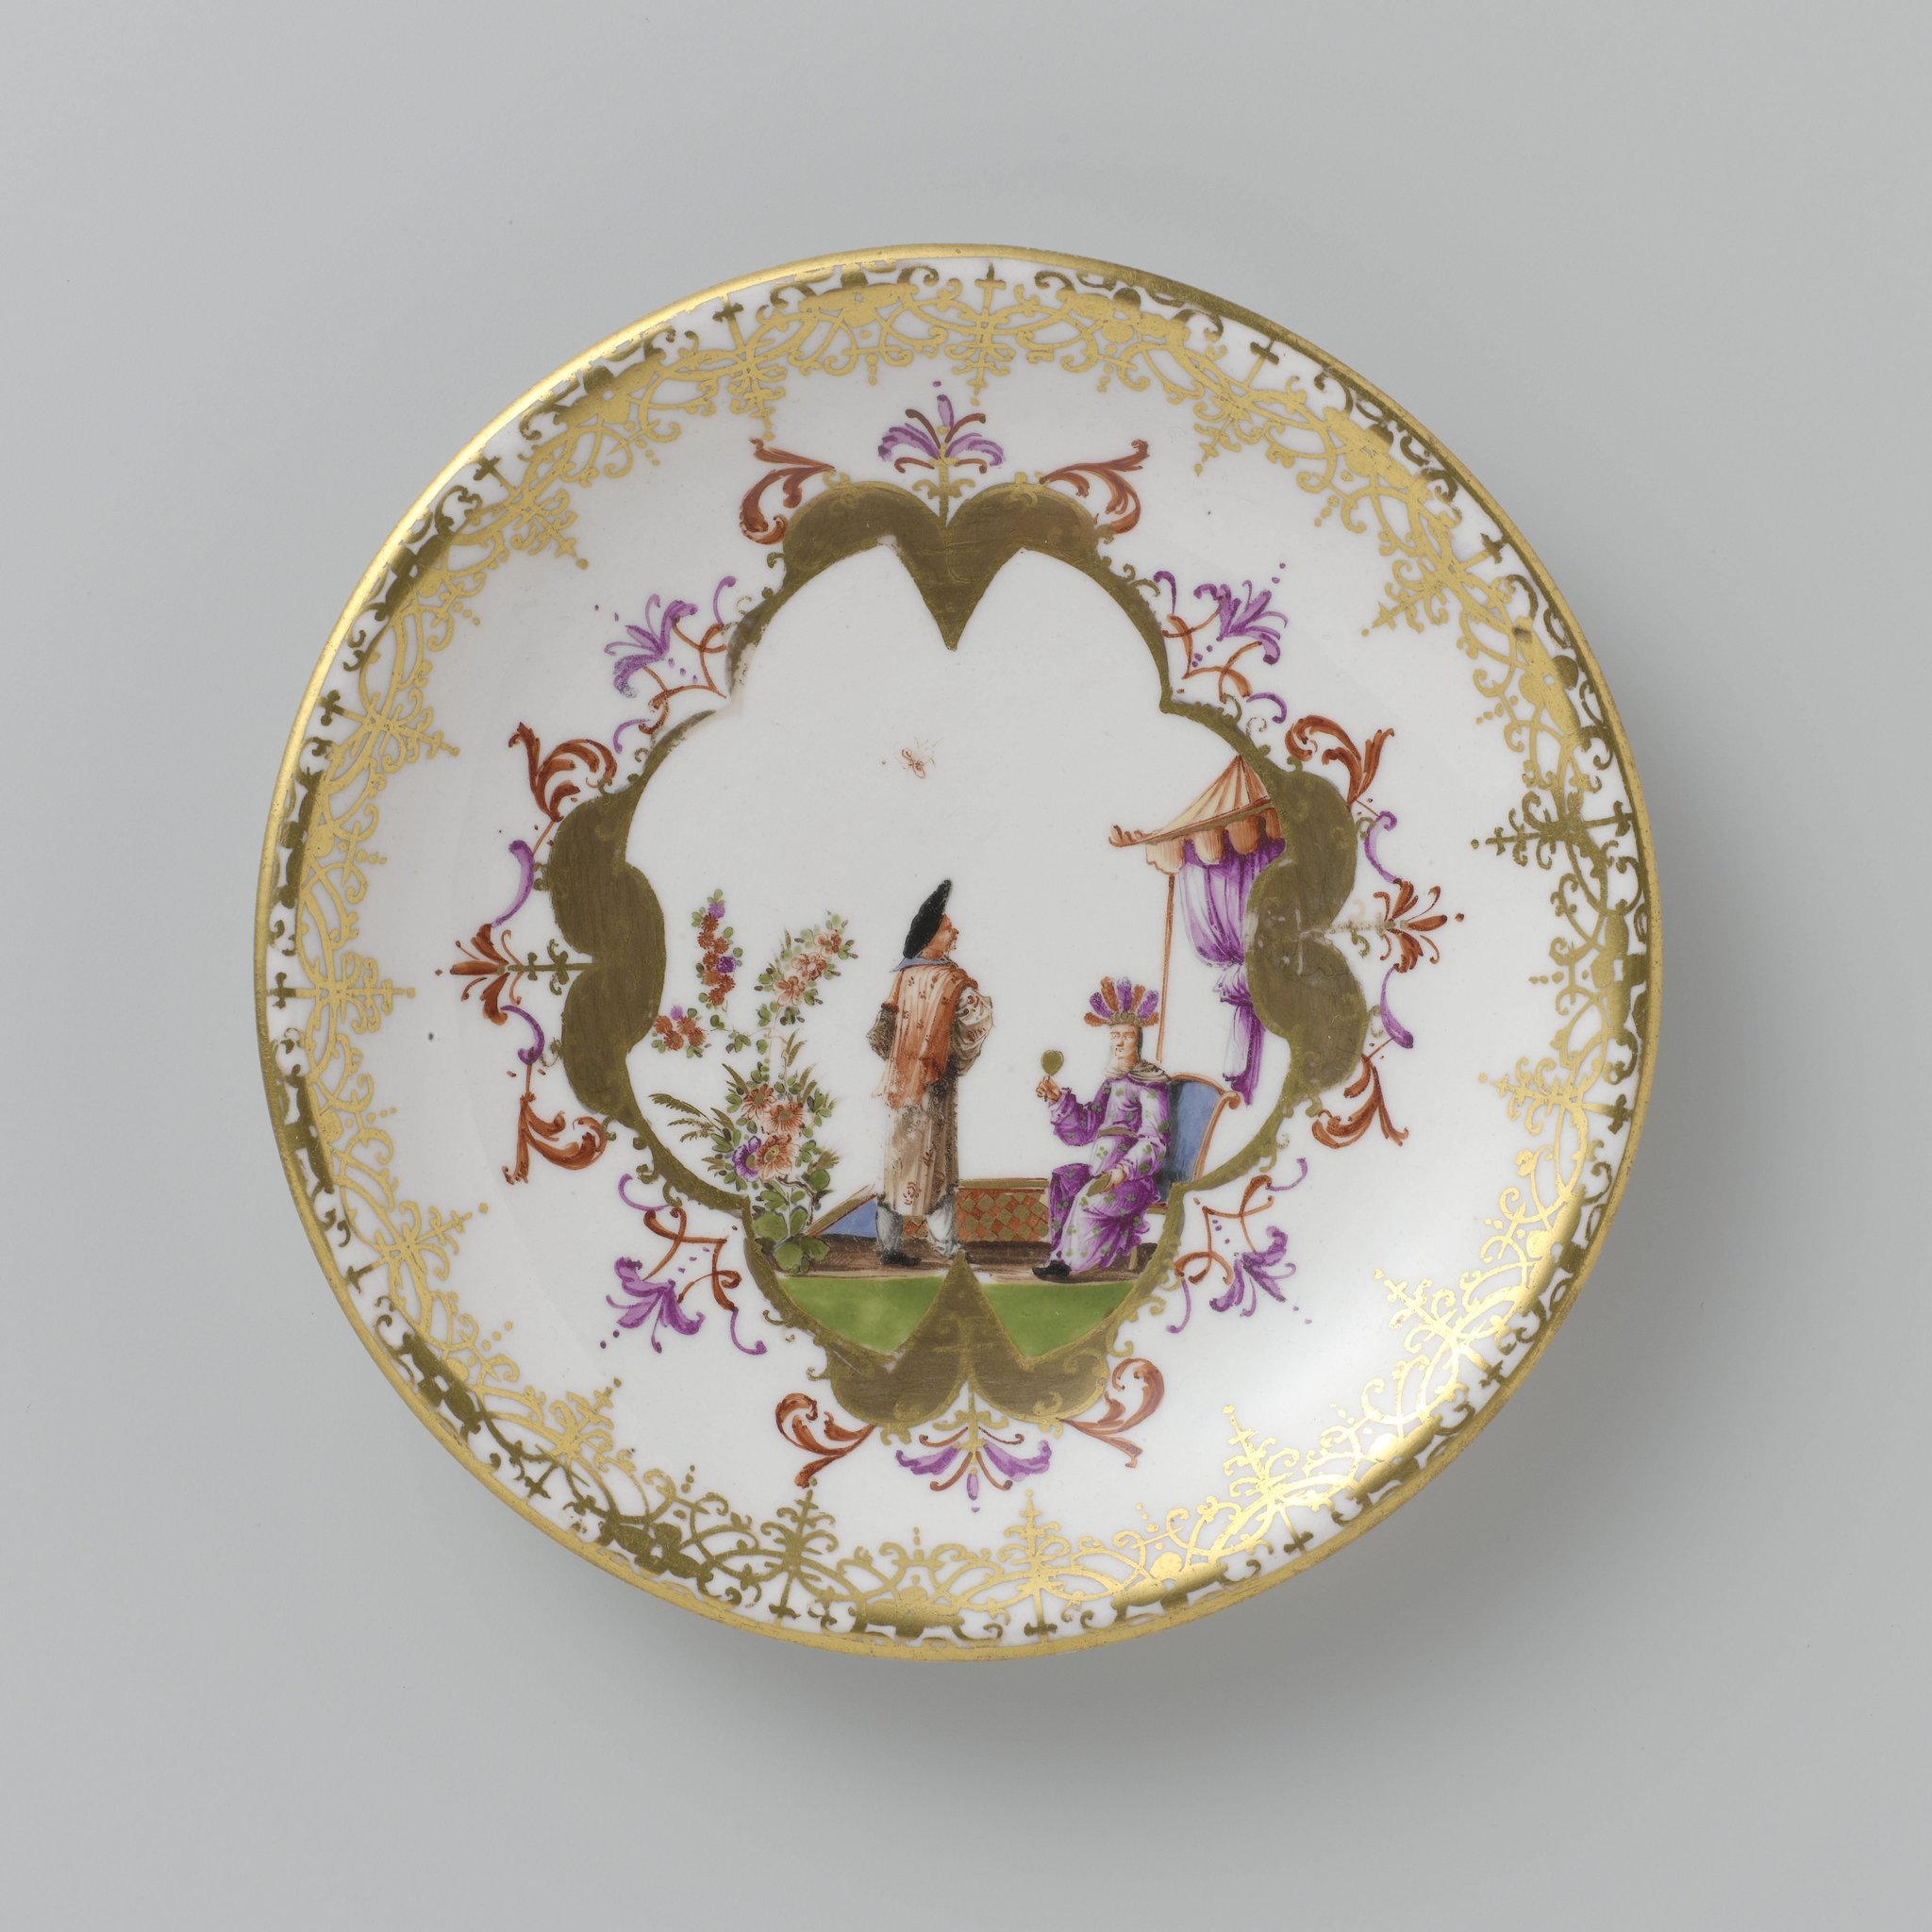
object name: platter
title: Cup and saucer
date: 1725-1730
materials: porcelain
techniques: painted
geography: meissen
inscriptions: label: ‘SAMMLUNG / Dr. FRANZ OPPENHEIMER’, number: ‘178.’, mark, factory mark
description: Meissener Porzellan Manufaktur Meissen, c. 1725–1730 hard-paste porcelain